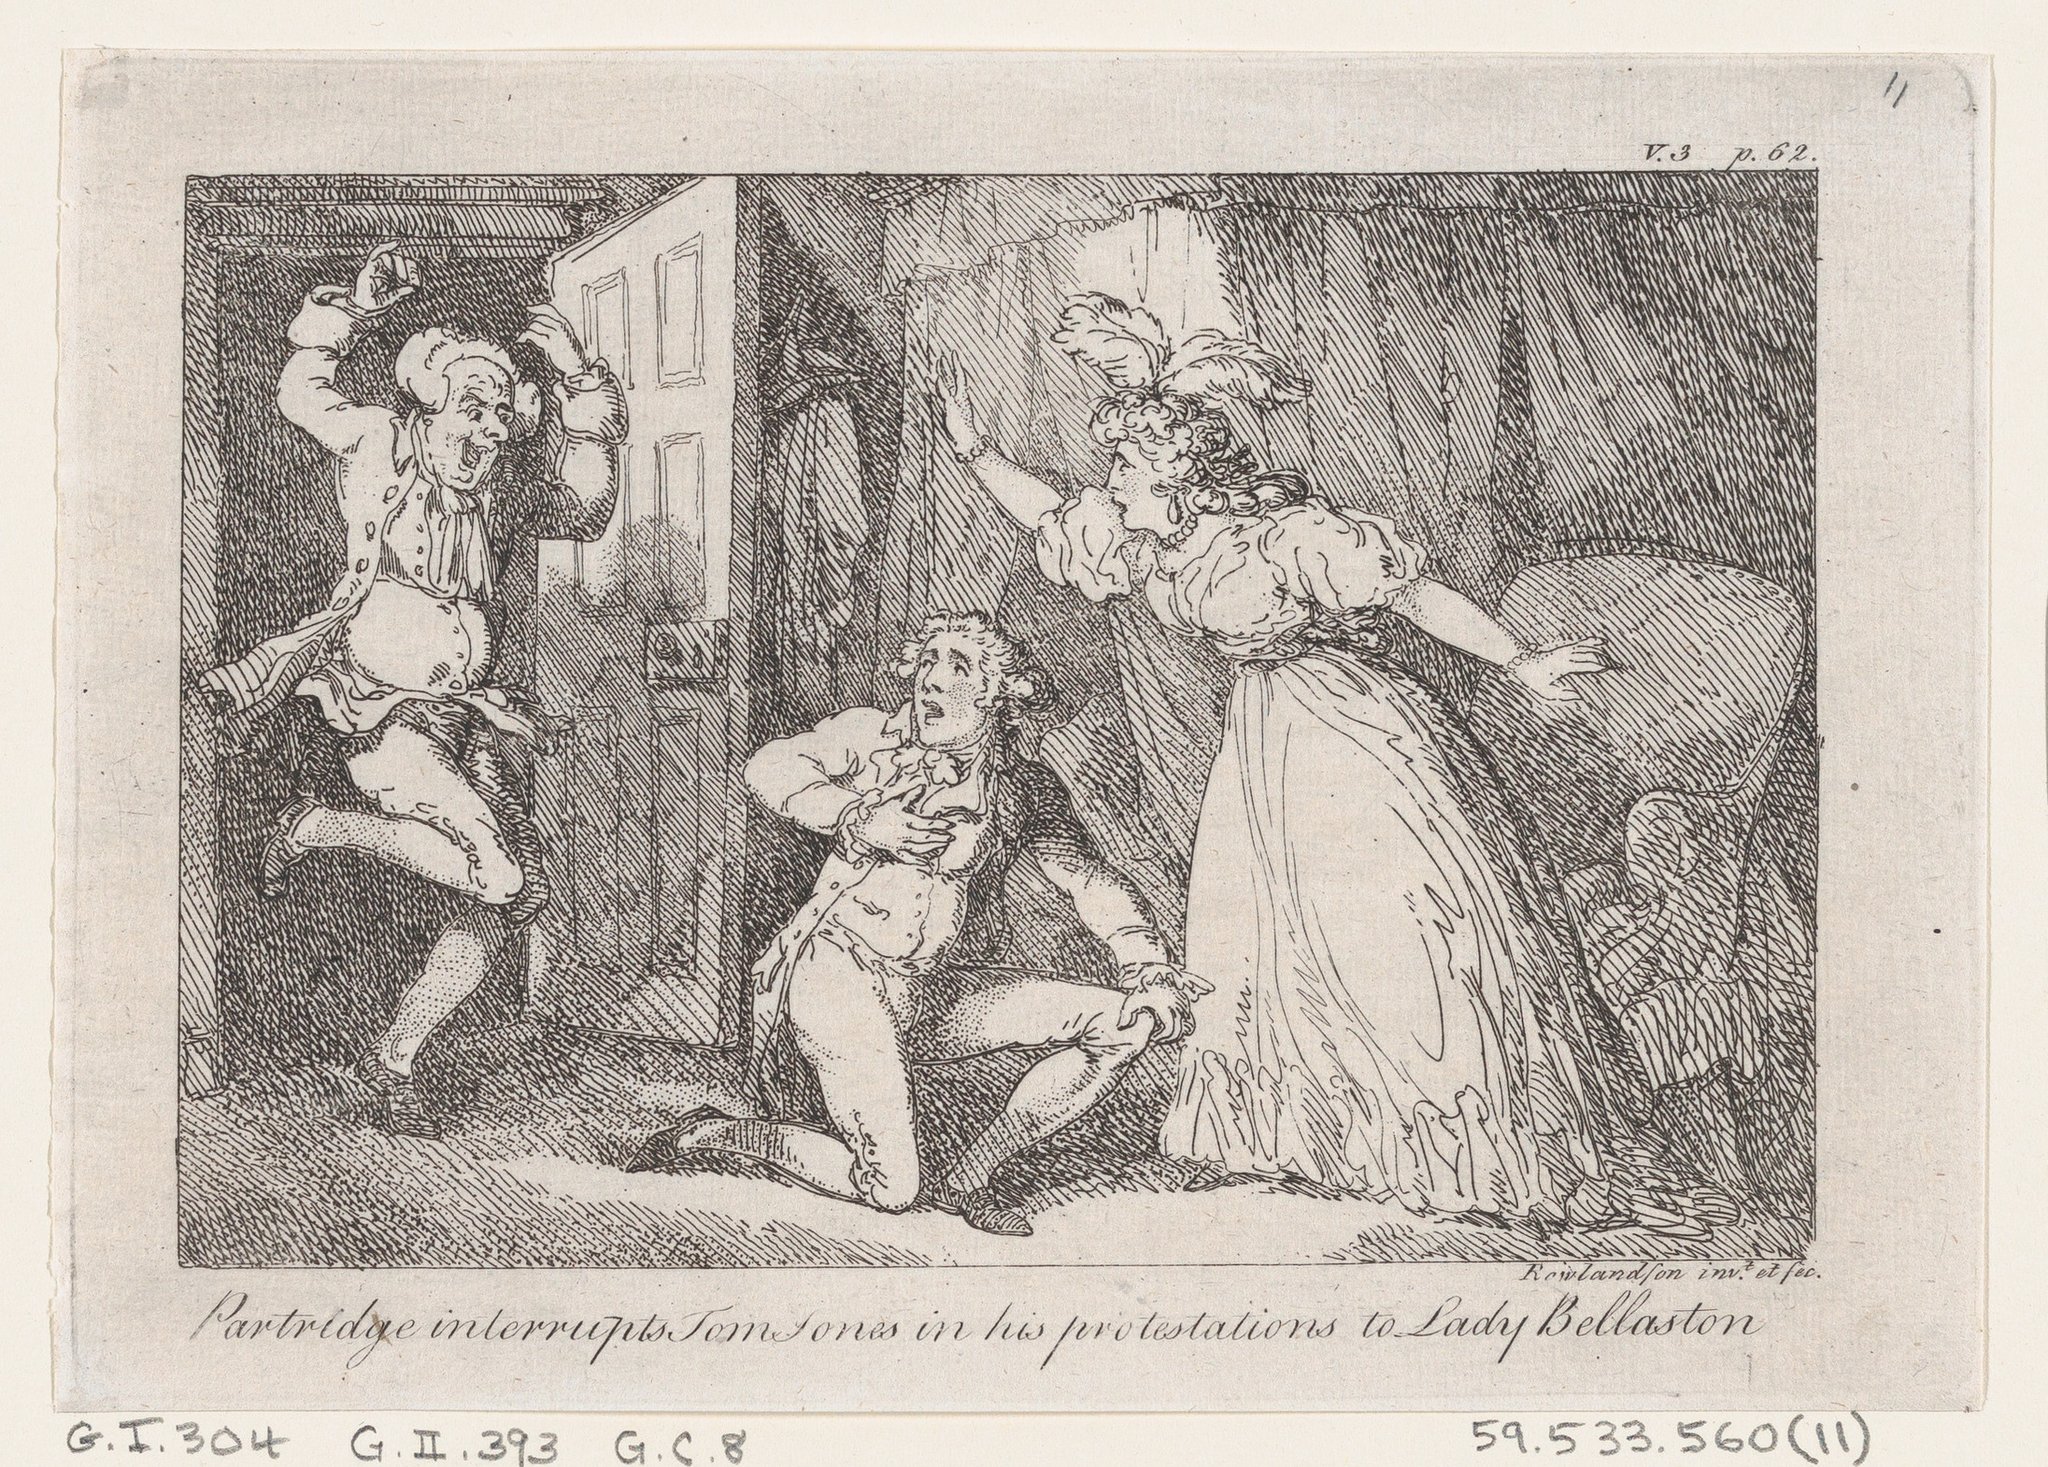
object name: print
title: Partridge Interrupts Tom Jones in his Protestations to Lady Bellaston, from "The History of Tom Jones, a Foundling"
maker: thomas rowlandson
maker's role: artist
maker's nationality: british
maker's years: 1757-1827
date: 1792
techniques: etching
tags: bedrooms,men,women